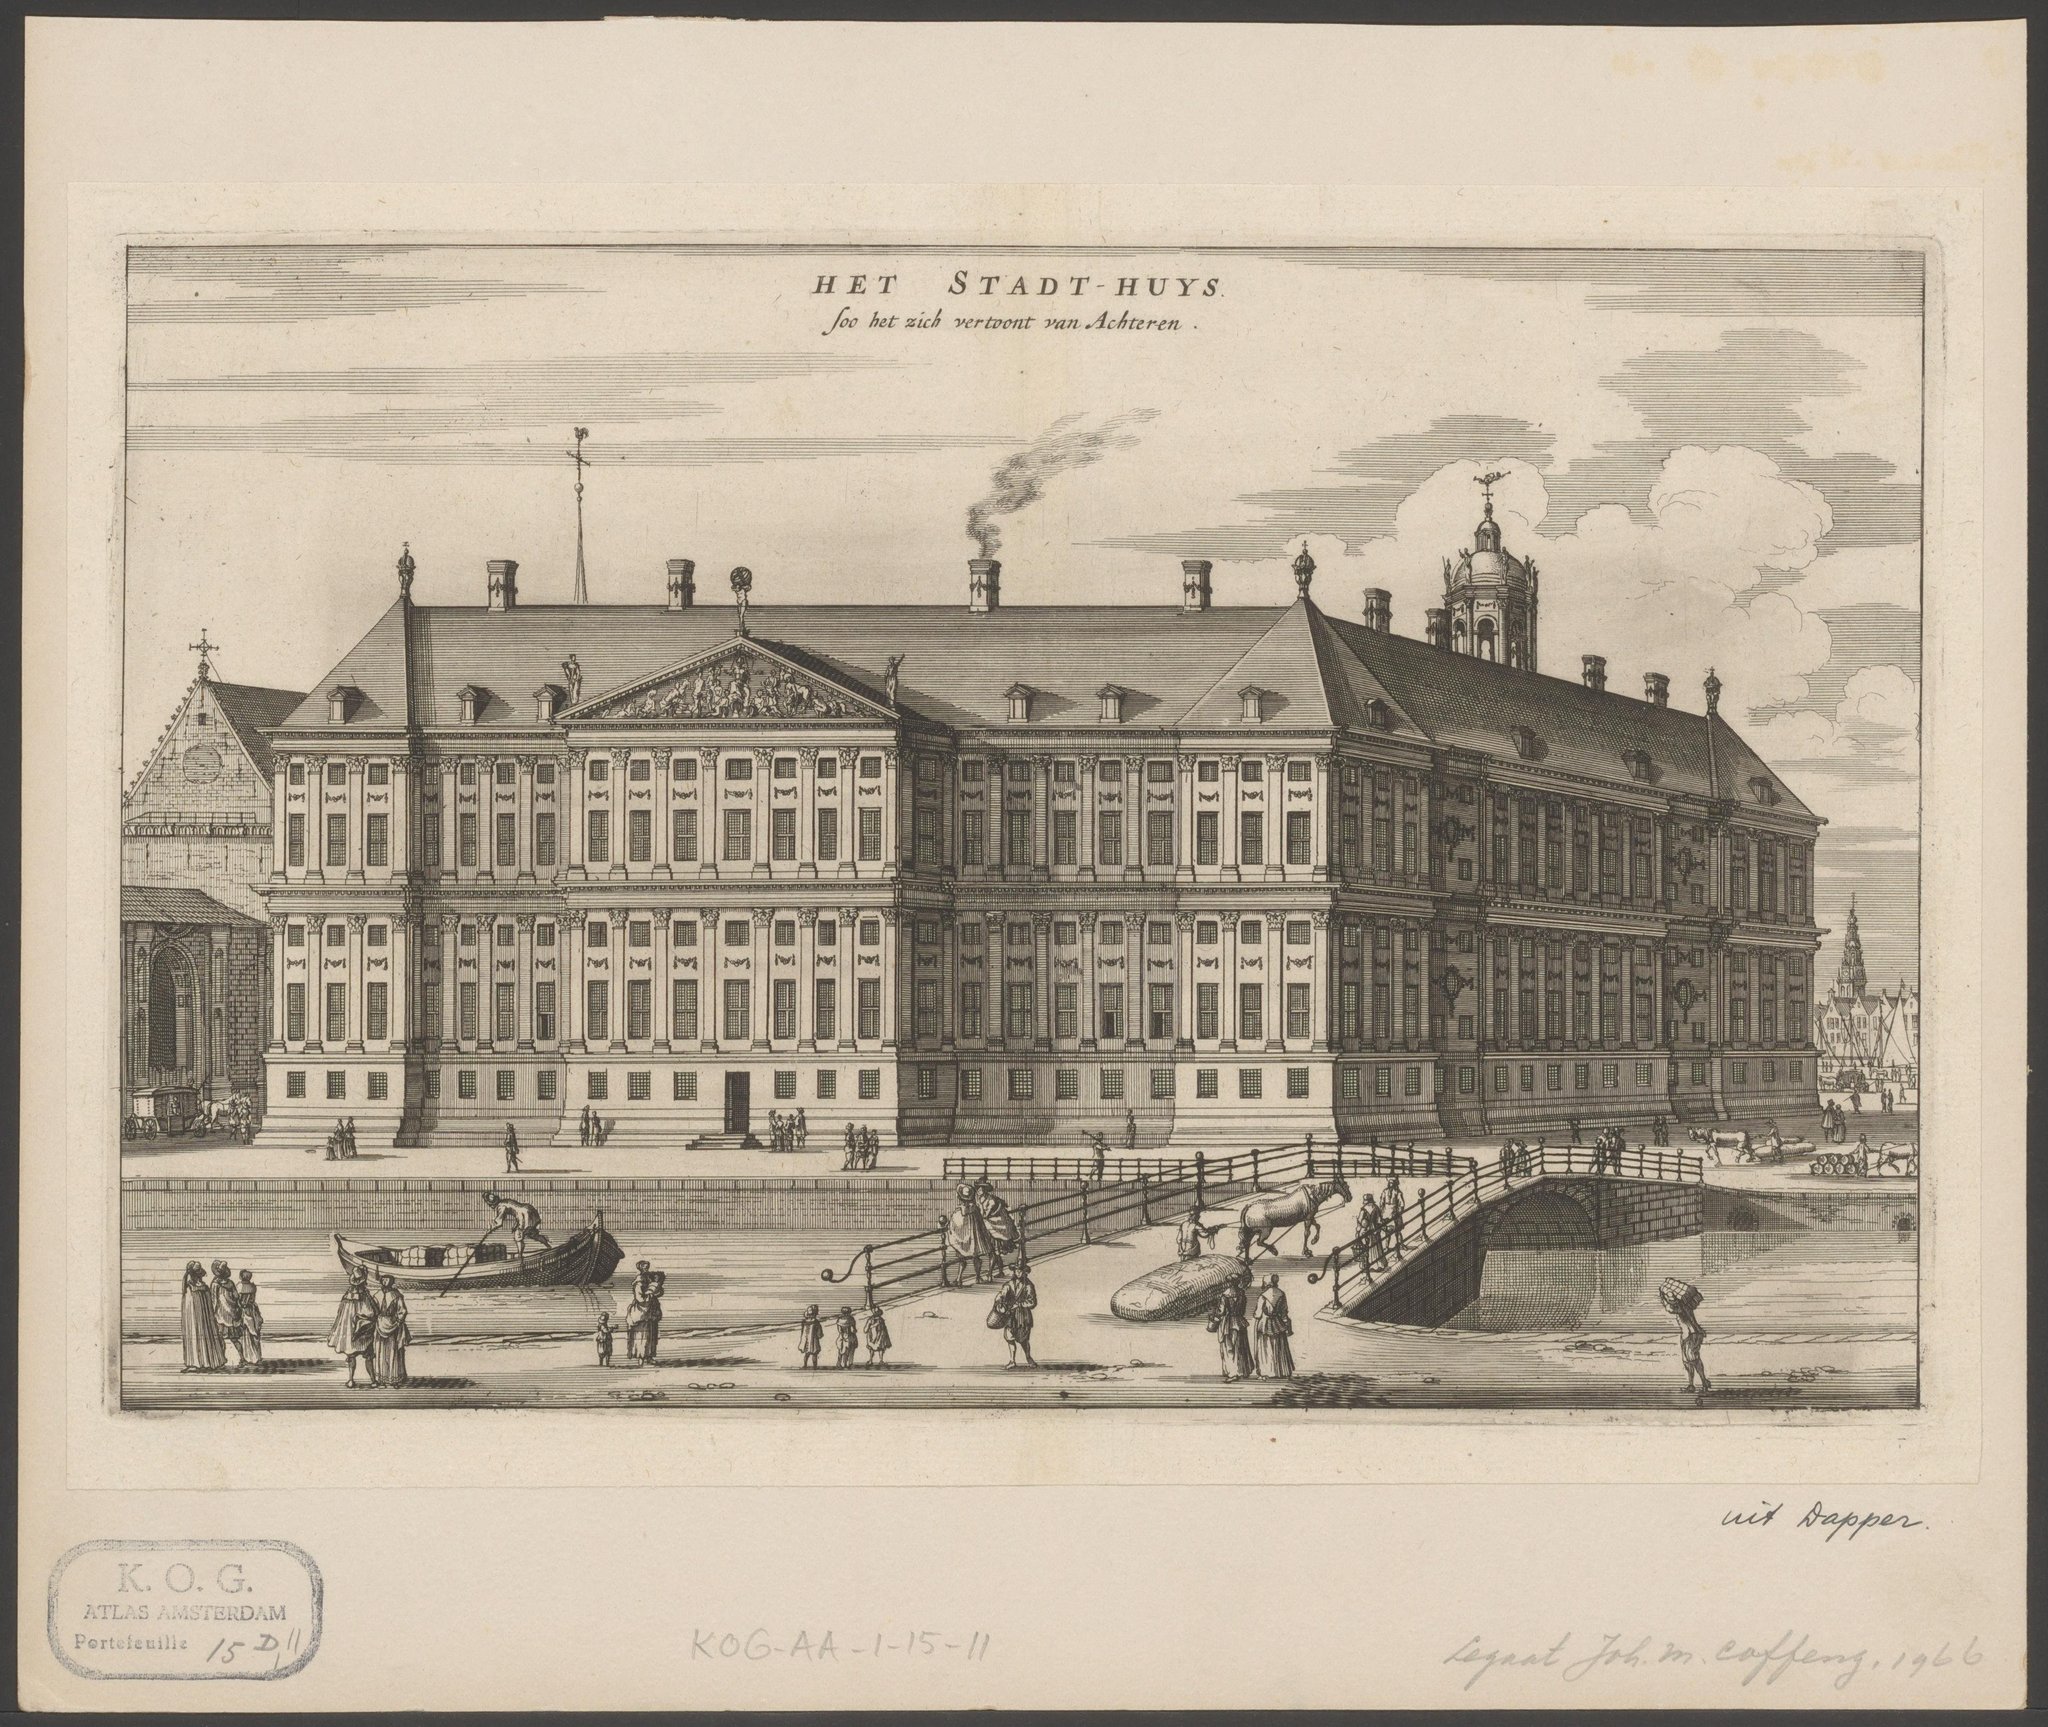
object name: print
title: Het Stadt-huys. soo het zich vertoont van Achteren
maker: jacob van meurs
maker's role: draughtsman, print maker, publisher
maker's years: 1619-1680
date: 1663-1664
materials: paper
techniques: engraving, etching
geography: amsterdam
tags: city-view in general; 'veduta', canal, townhall, bridge in city across river, canal, etc.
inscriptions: inscription: ‘Legaat Joh. M. Coffeng. 1966’, collector's mark: ‘15D,11’ Lugt 1641b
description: Huidige staat van prent ook gebruikt in: Dapper, Olfert. Historische beschryving der stadt Amsterdam: waer in de voornaemste geschiedenissen (na een kort verhael van gansch Hollant en d'omleggende dorpen (…). Amsterdam: Jacob van Meurs, 1663.* En in: Zesen, Philipp von. Beschreibung der Stadt Amsterdam: darinnen von derselben ersten Ursprunge bis auf gegenwärtigen Zustand (…). Amsterdam: Joachim Nosche, 1664. * In sommige exemplaren van deze uitgave komt de huidige staat van de prent voor. In andere exemplaren is een latere staat ingebonden, waarop onder de Nederlandse een Franse titel is toegevoegd.